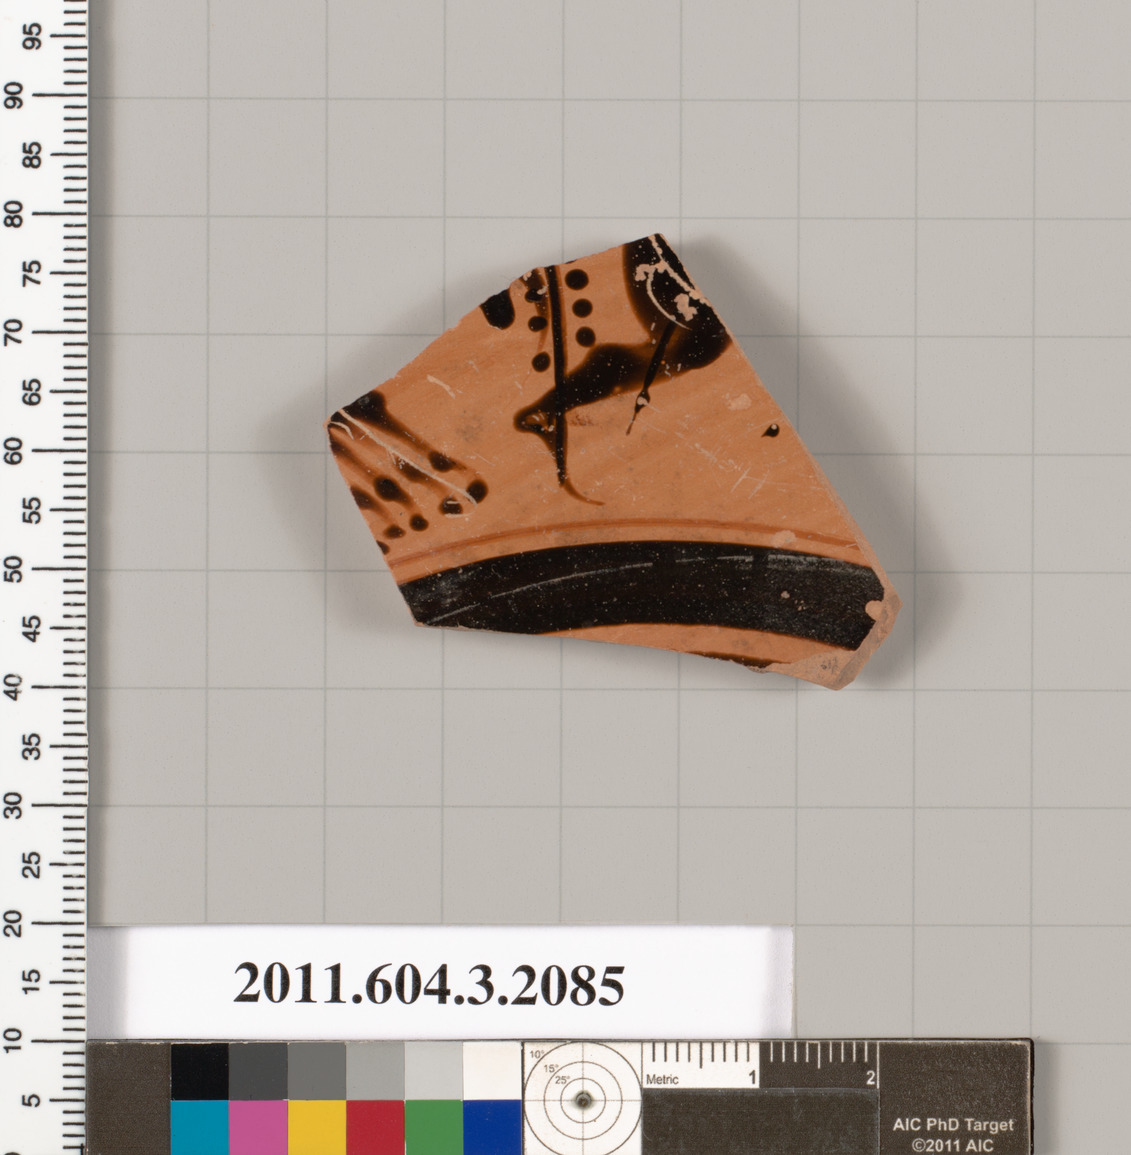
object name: kylix fragment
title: Terracotta fragment of a kylix (drinking cup)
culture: greek, attic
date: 534-468 BCE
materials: terracotta